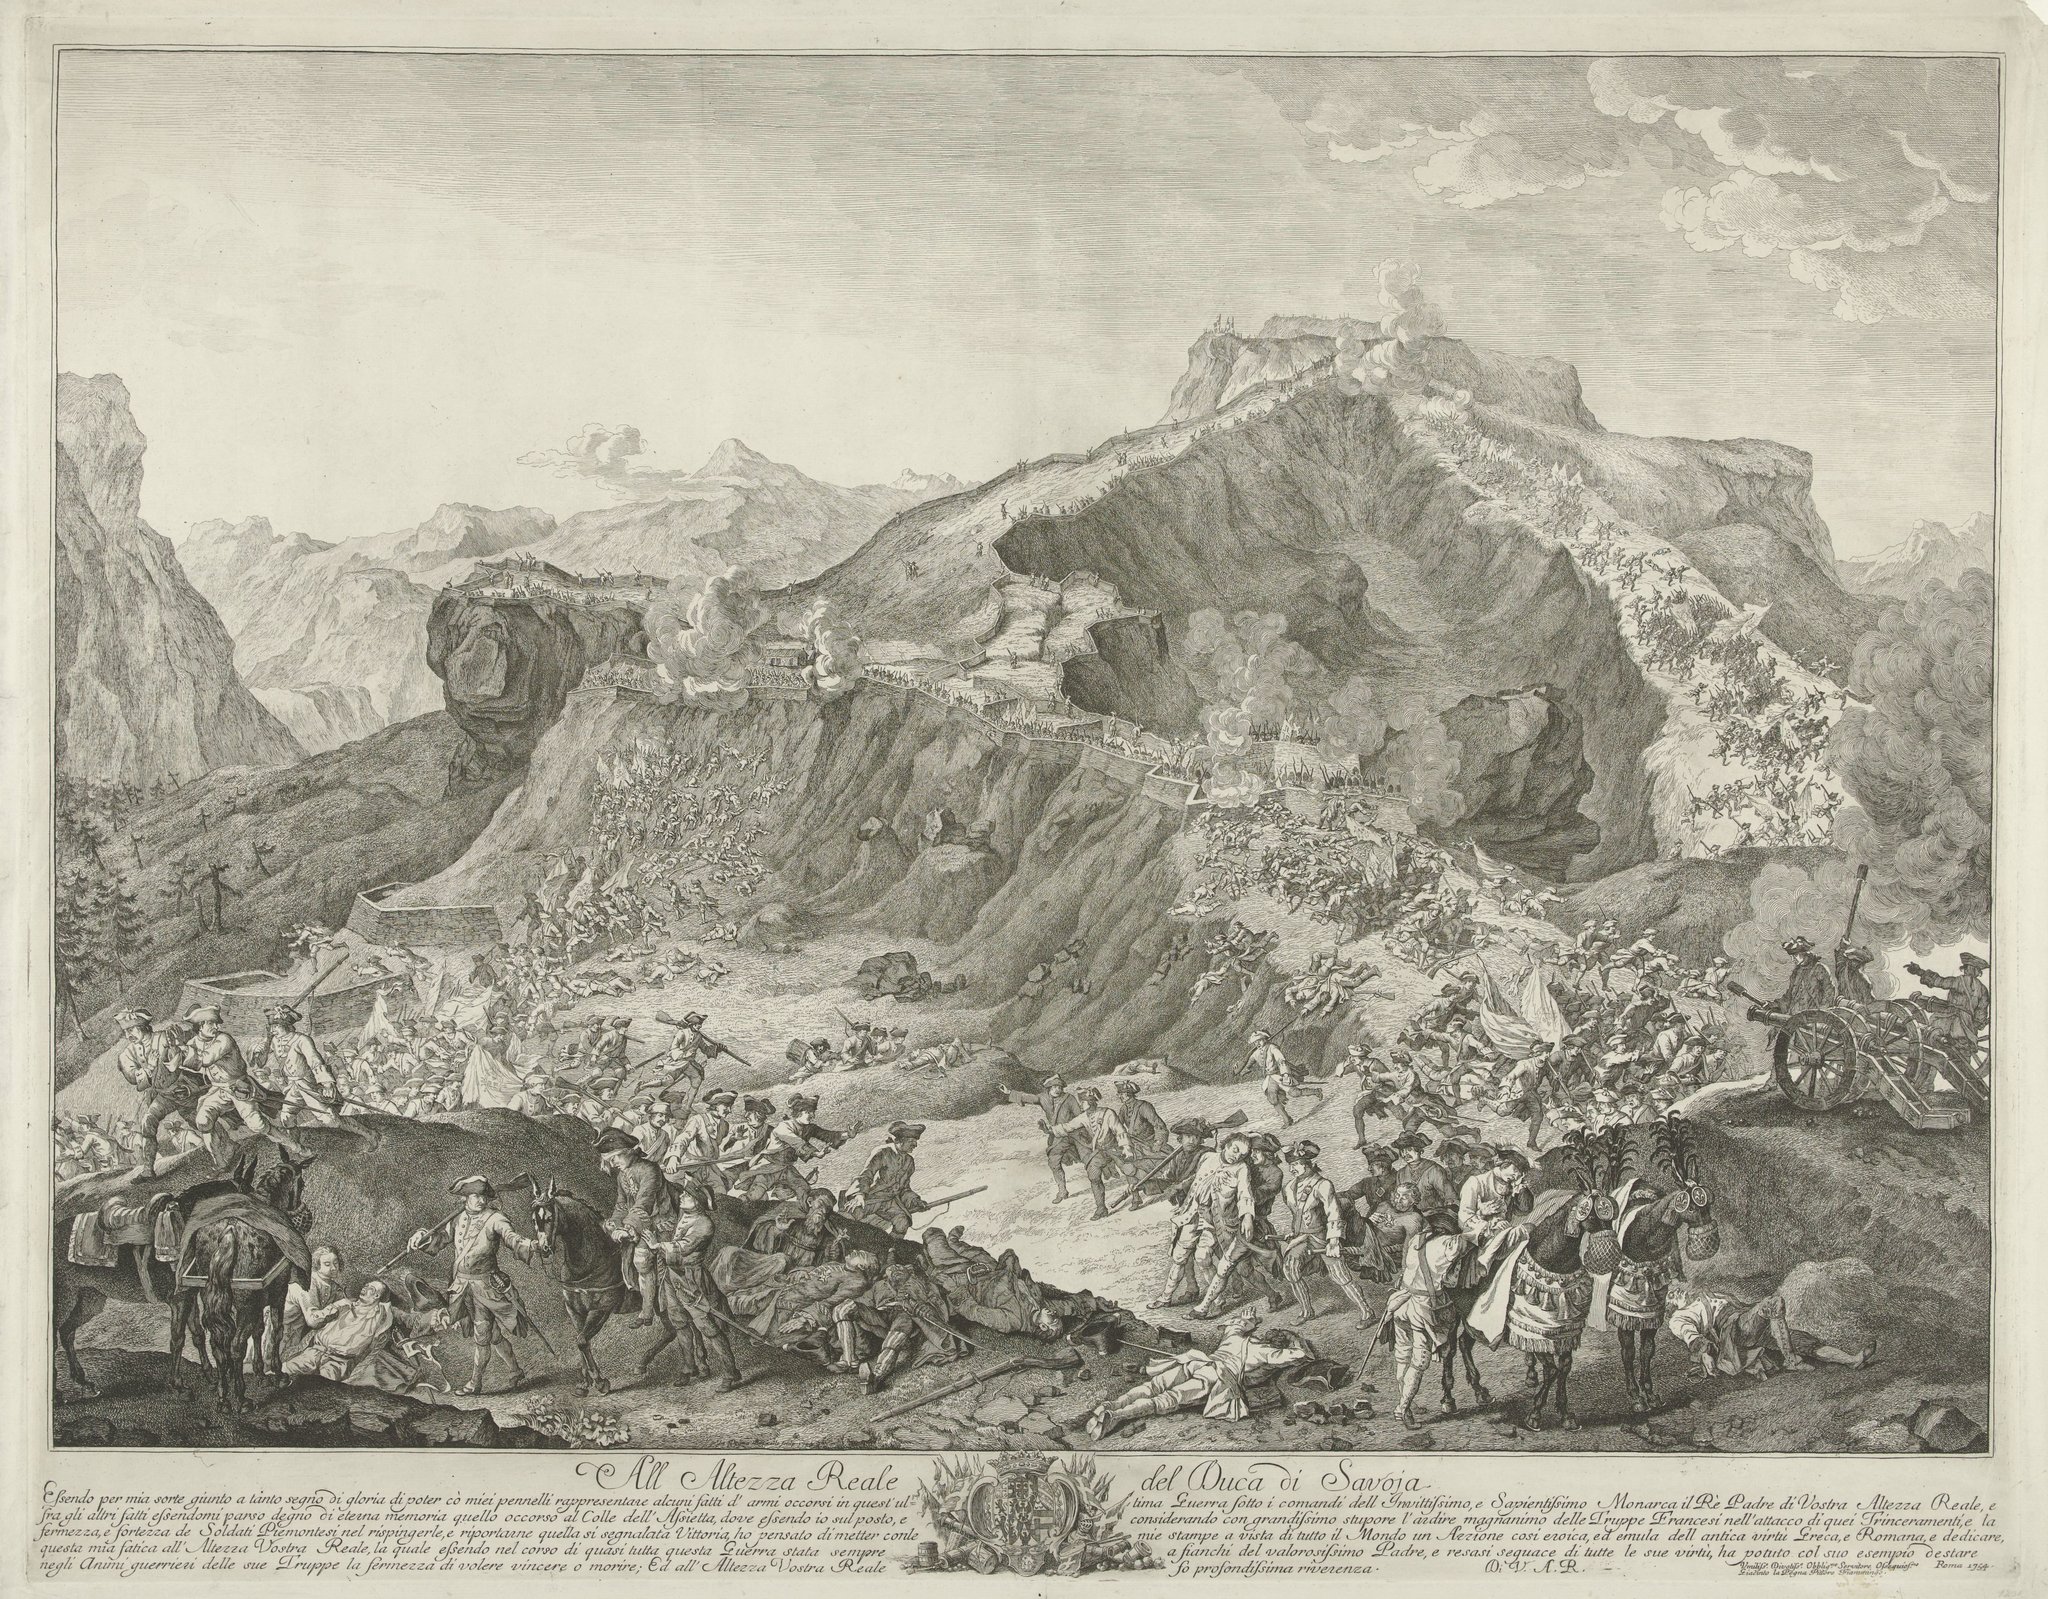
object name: print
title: Aanval op de bergvesting Colle dell'Assietta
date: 1754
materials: paper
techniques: etching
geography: rome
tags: (military) attack (+ ranks; division of armed forces), priest at the bed of a dying person ~ extreme unction (+ variant), transport of the sick, wounded and dead by vehicle, putting the enemy to flight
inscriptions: collector's mark: Lugt 2228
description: Slag tussen de Fransen en de Piemontezen op de Colle dell'Assietta. De Fransen worden van de berg teruggedreven. Op de voorgrond worden gewonden verzorgd en afgevoerd. Een priester zegent een stervende. In de marge het wapenschild van de hertog van Savoye en een vijfregelig onderschrift met een opdracht in het Italiaans.